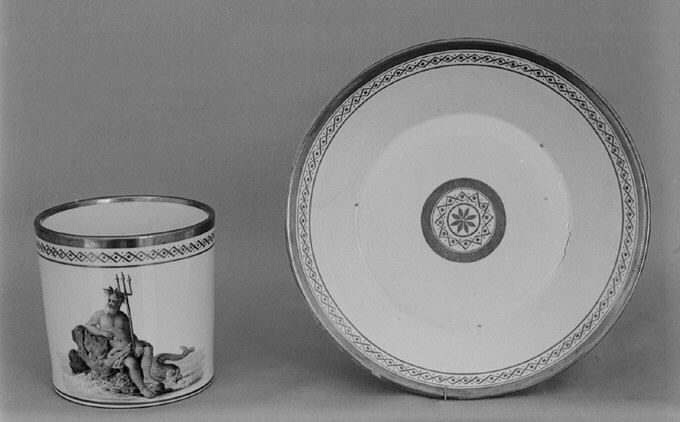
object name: cup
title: Cup (part of a coffee service)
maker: nymphenburg porcelain manufactory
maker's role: manufactory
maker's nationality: german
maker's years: 1747-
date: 1801-1833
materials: hard paste porcelain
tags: men